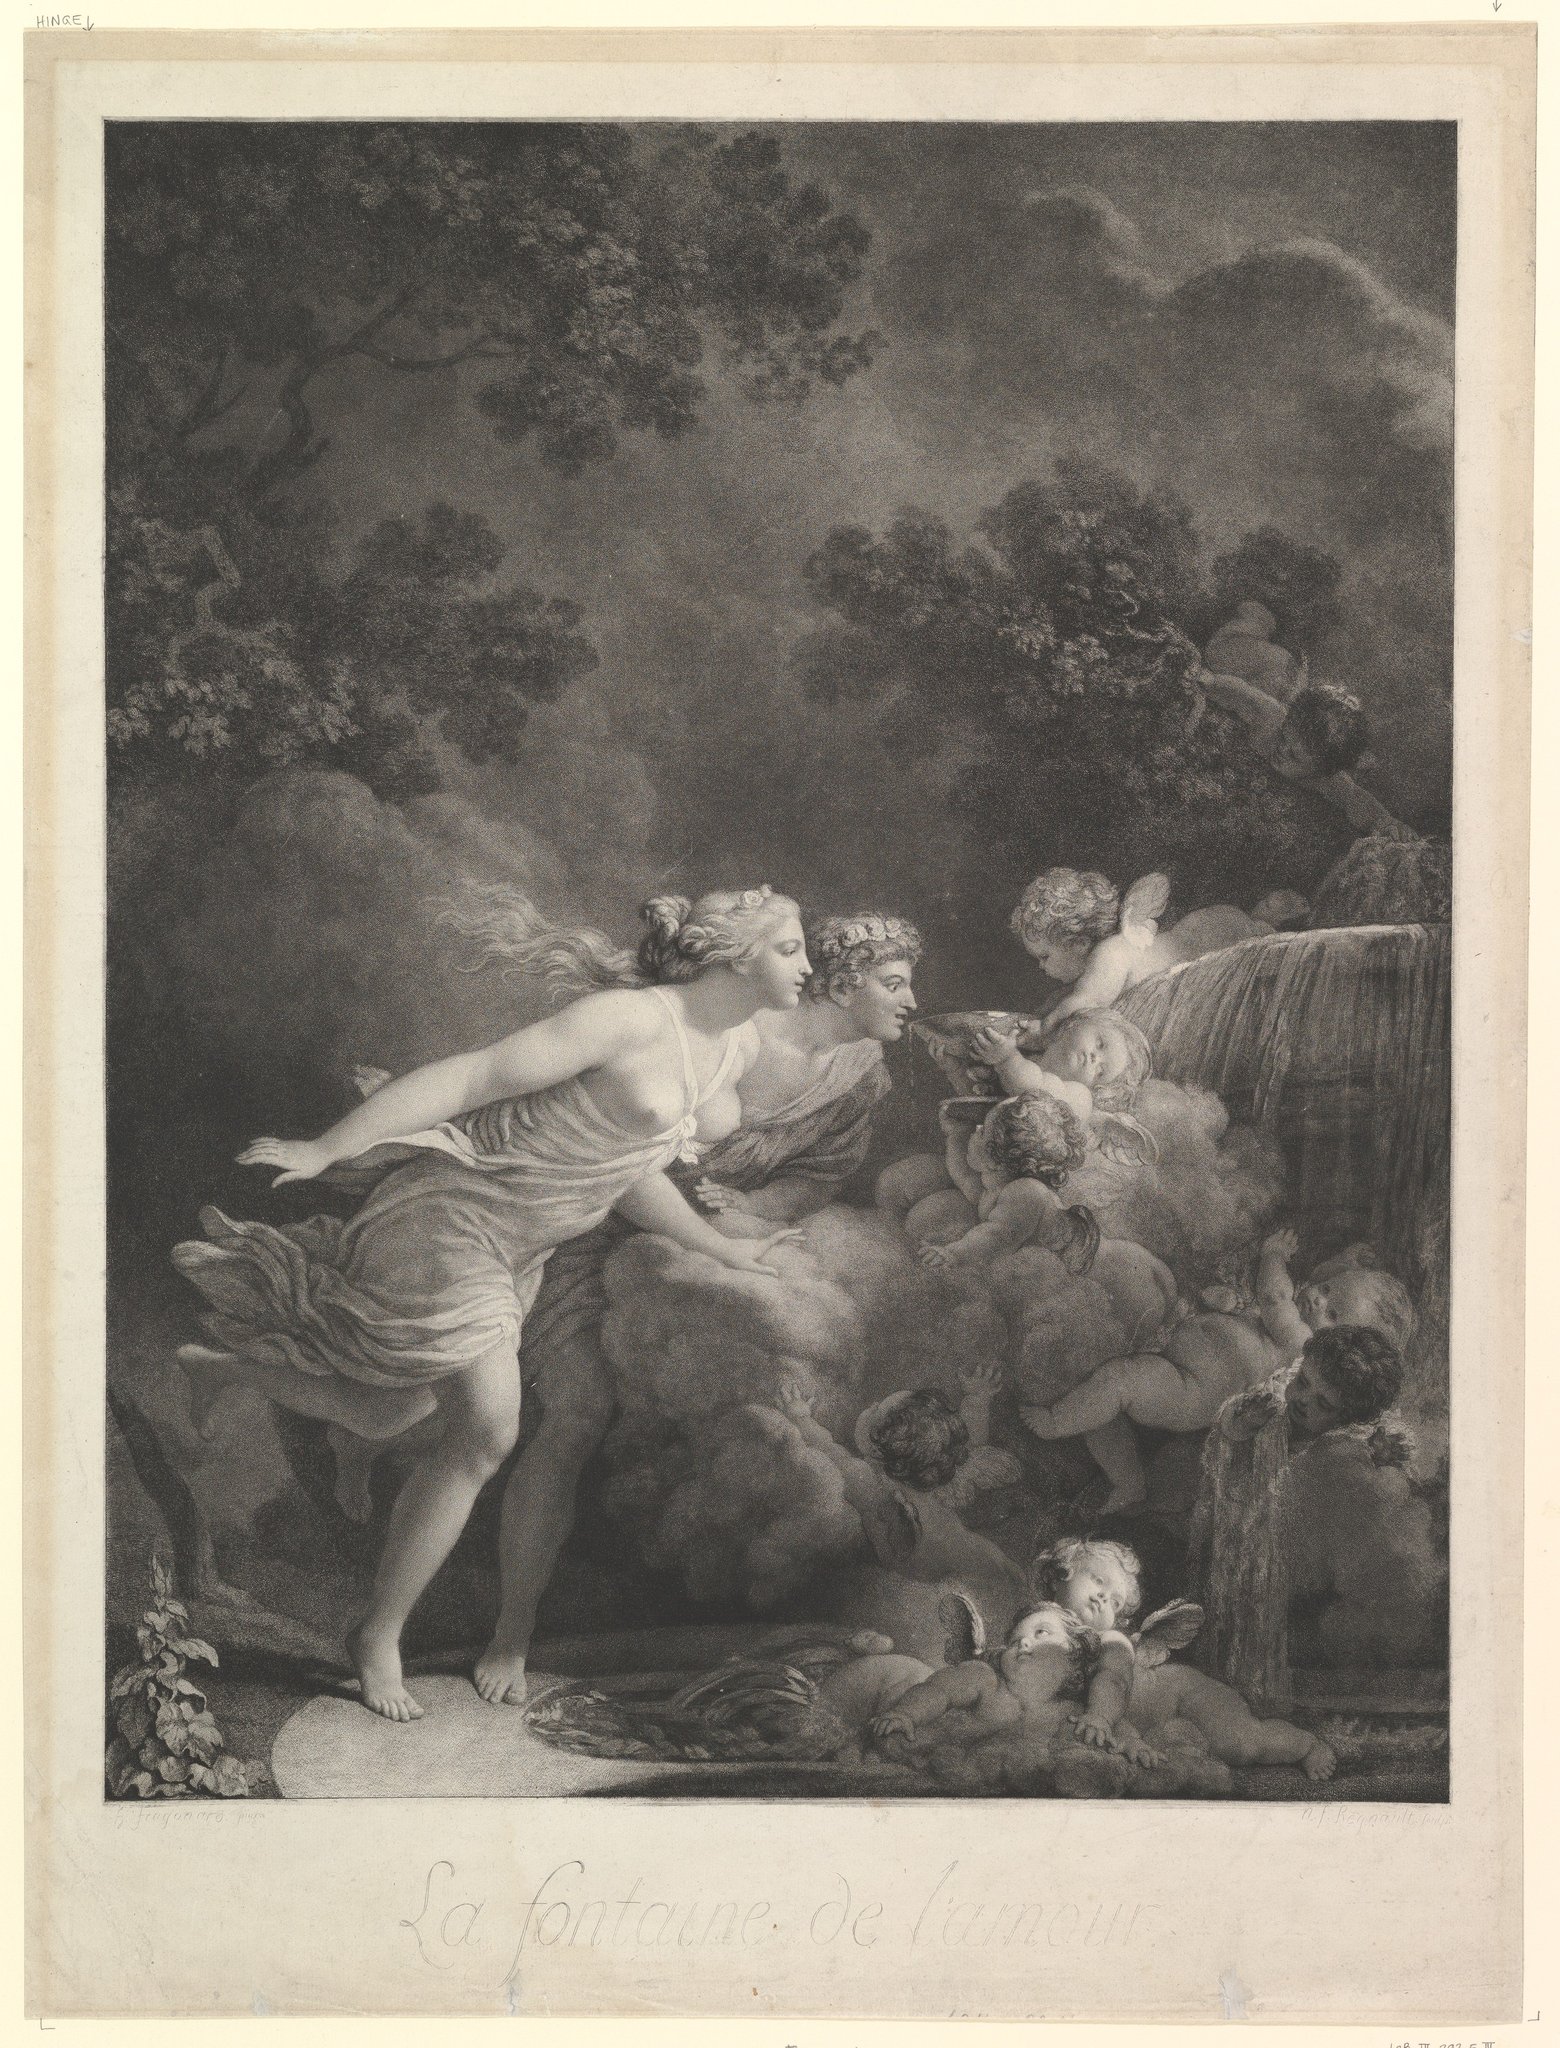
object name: print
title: La Fontaine d'Amour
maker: jean honoré fragonard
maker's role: artist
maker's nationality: french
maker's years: 1732-1806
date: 1785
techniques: etching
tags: fountains,men,lovers,women,forests,angels